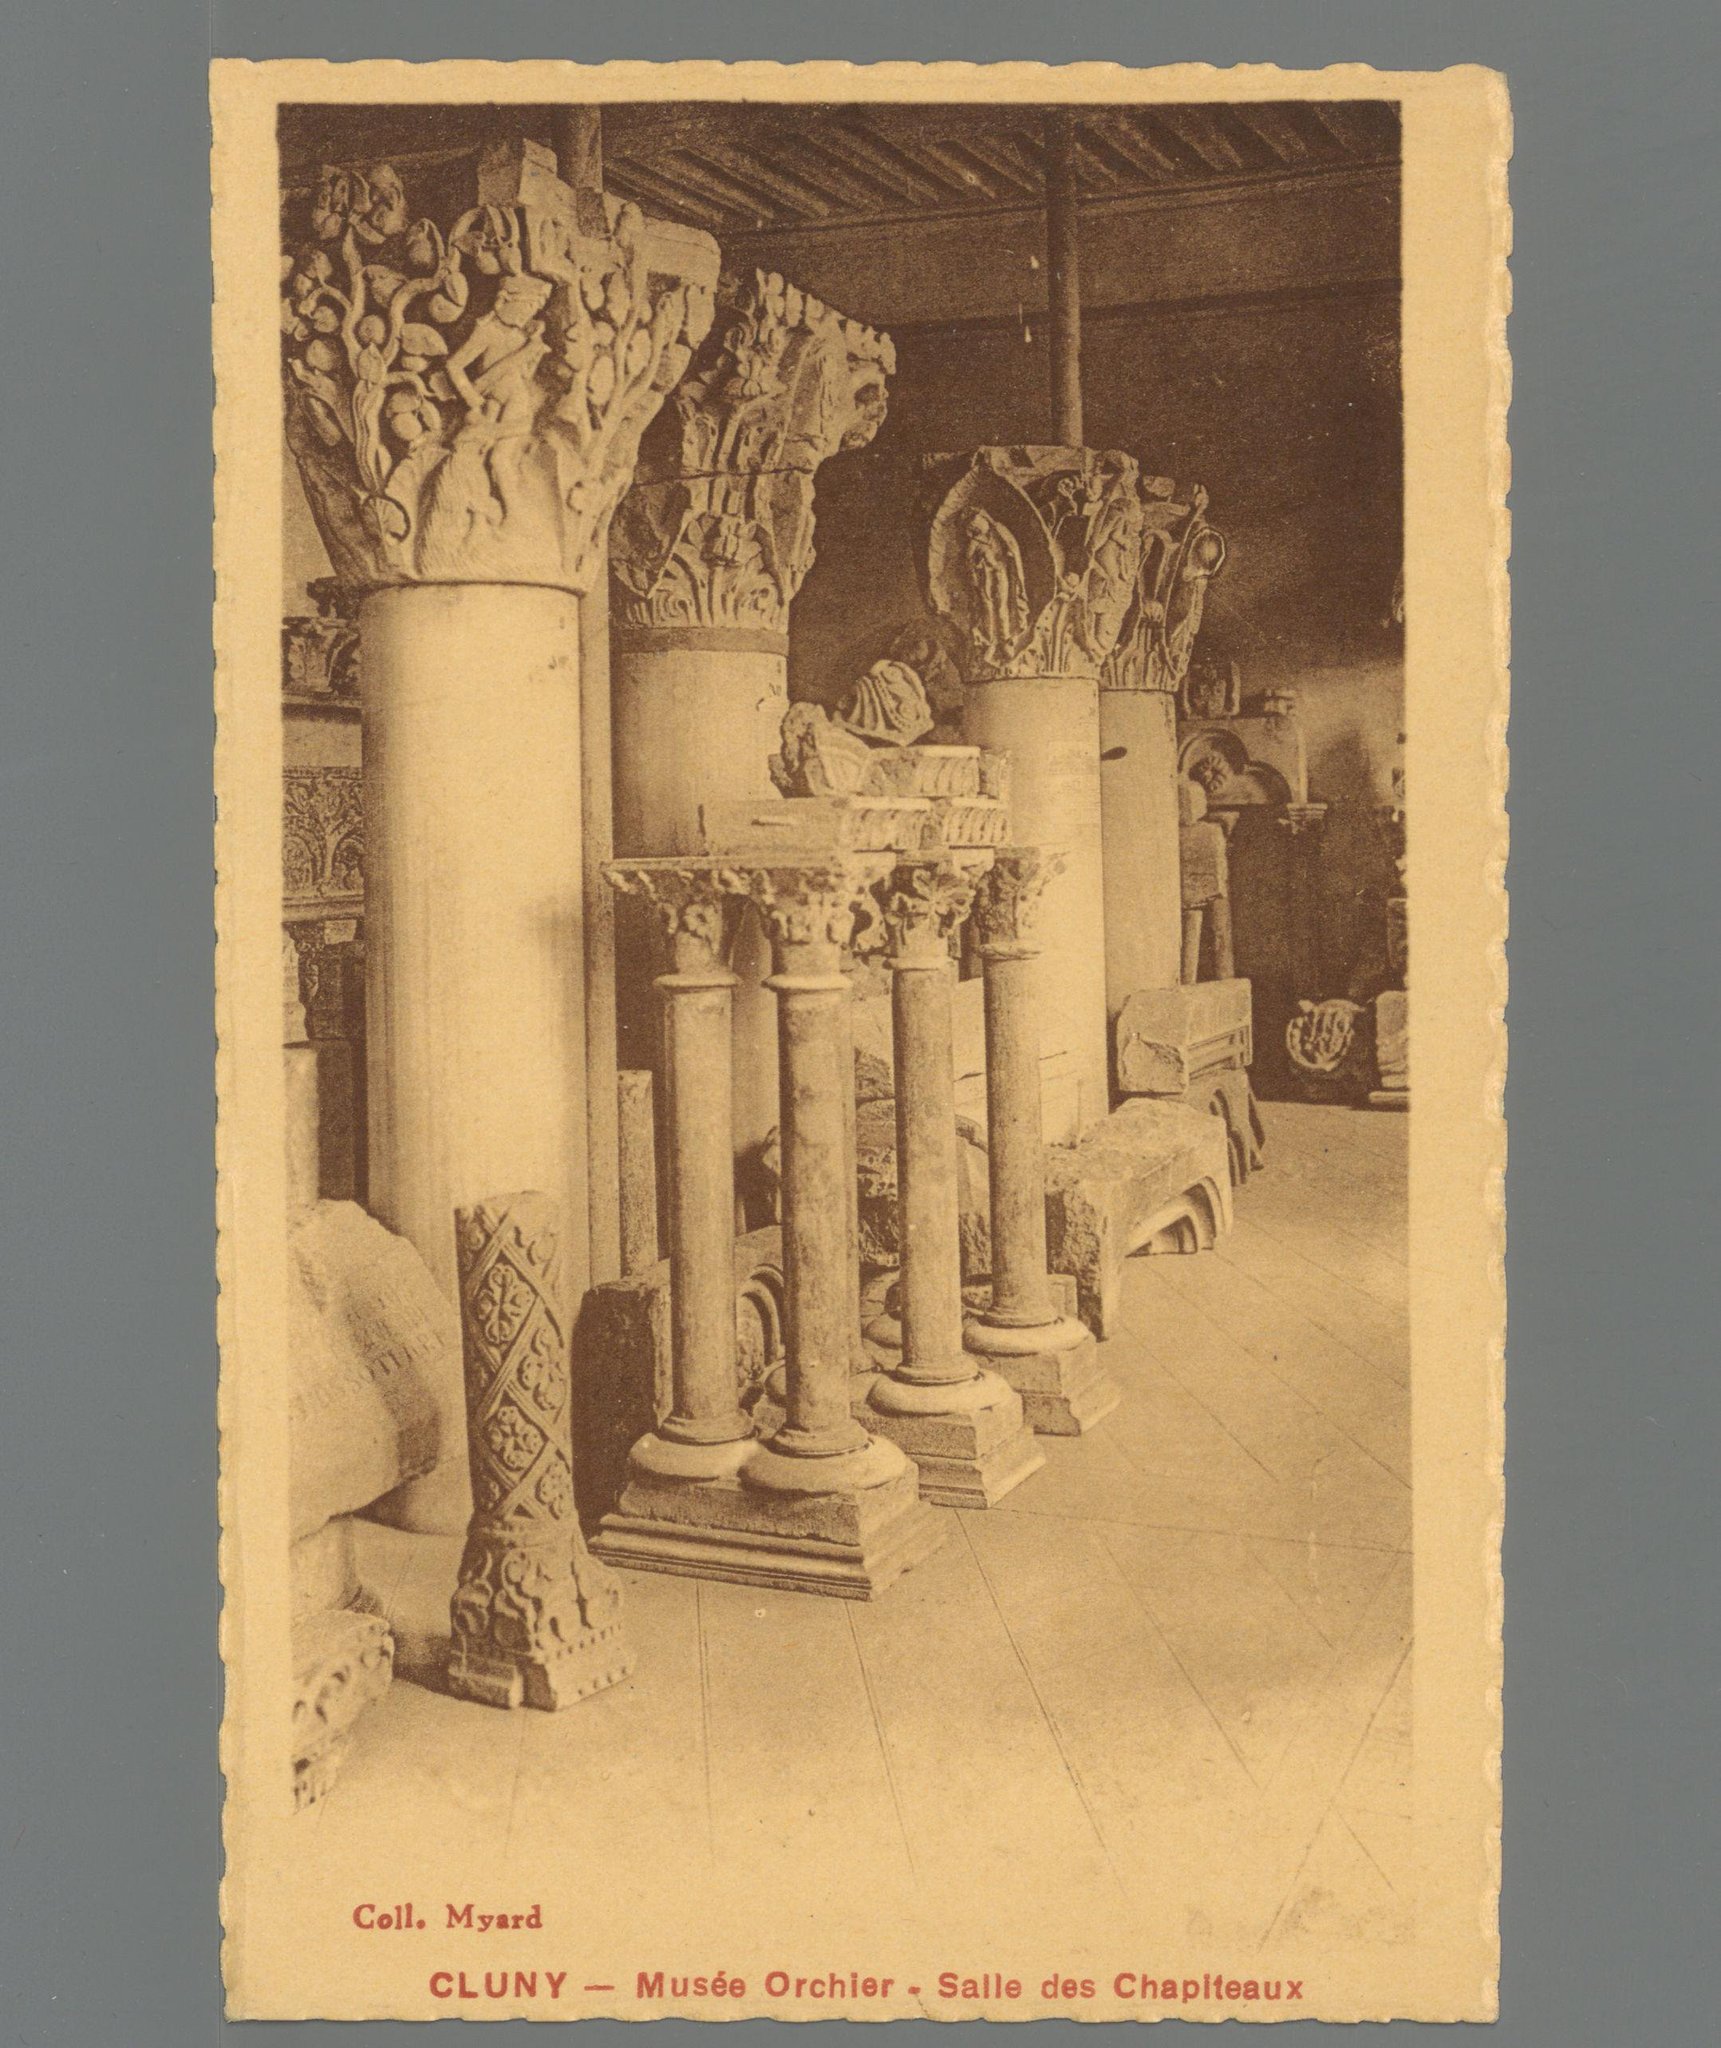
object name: ansichtkaart, prentbriefkaart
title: Cluny. Musée Orchier. Salle des Chapiteaux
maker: Anonymous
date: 1903-1930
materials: cardboard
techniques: photograph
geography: cluny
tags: permanent exhibition, museum, capital (~ column, pillar)